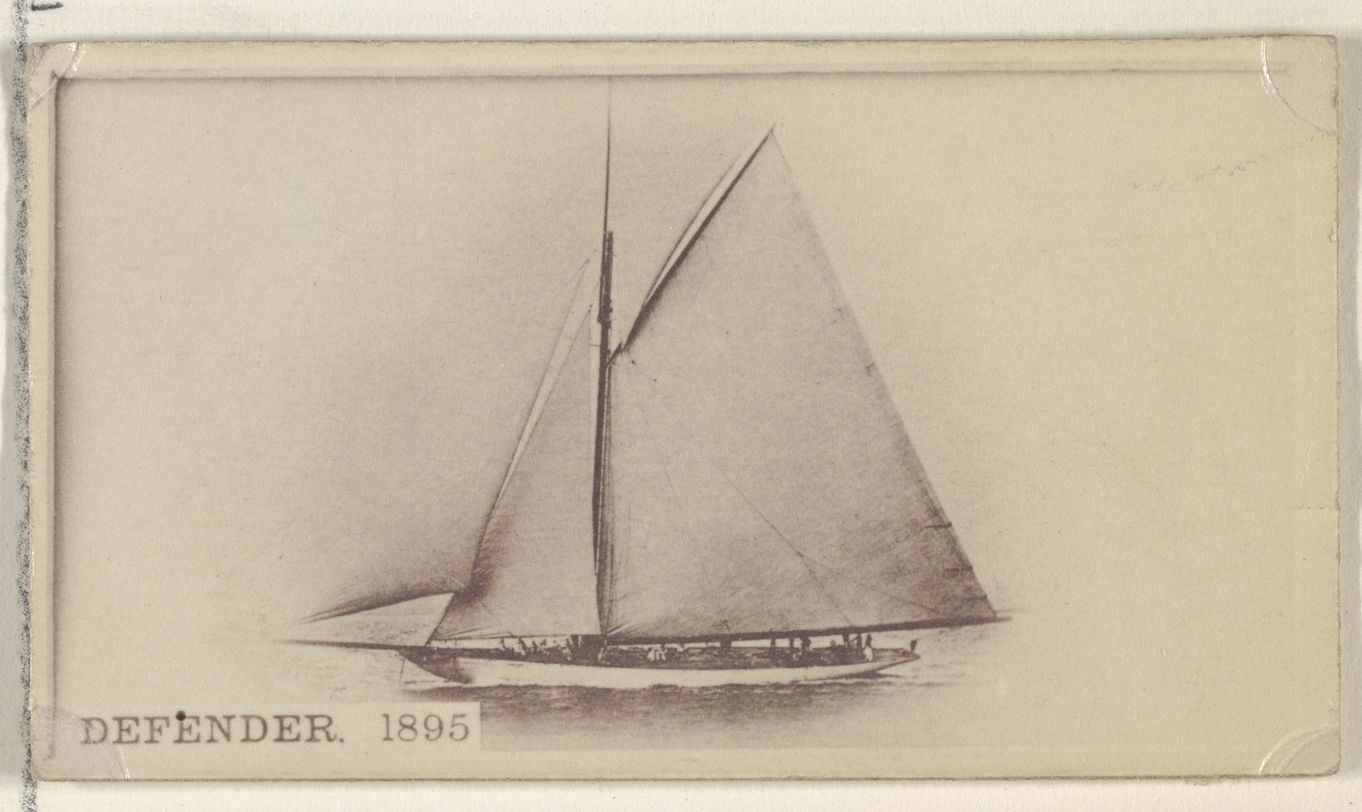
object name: photograph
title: Defender, 1895, from the Famous Ships series (N50) for Virginia Brights Cigarettes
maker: allen & ginter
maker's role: publisher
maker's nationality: american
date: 1895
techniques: albumen silver print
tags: ships